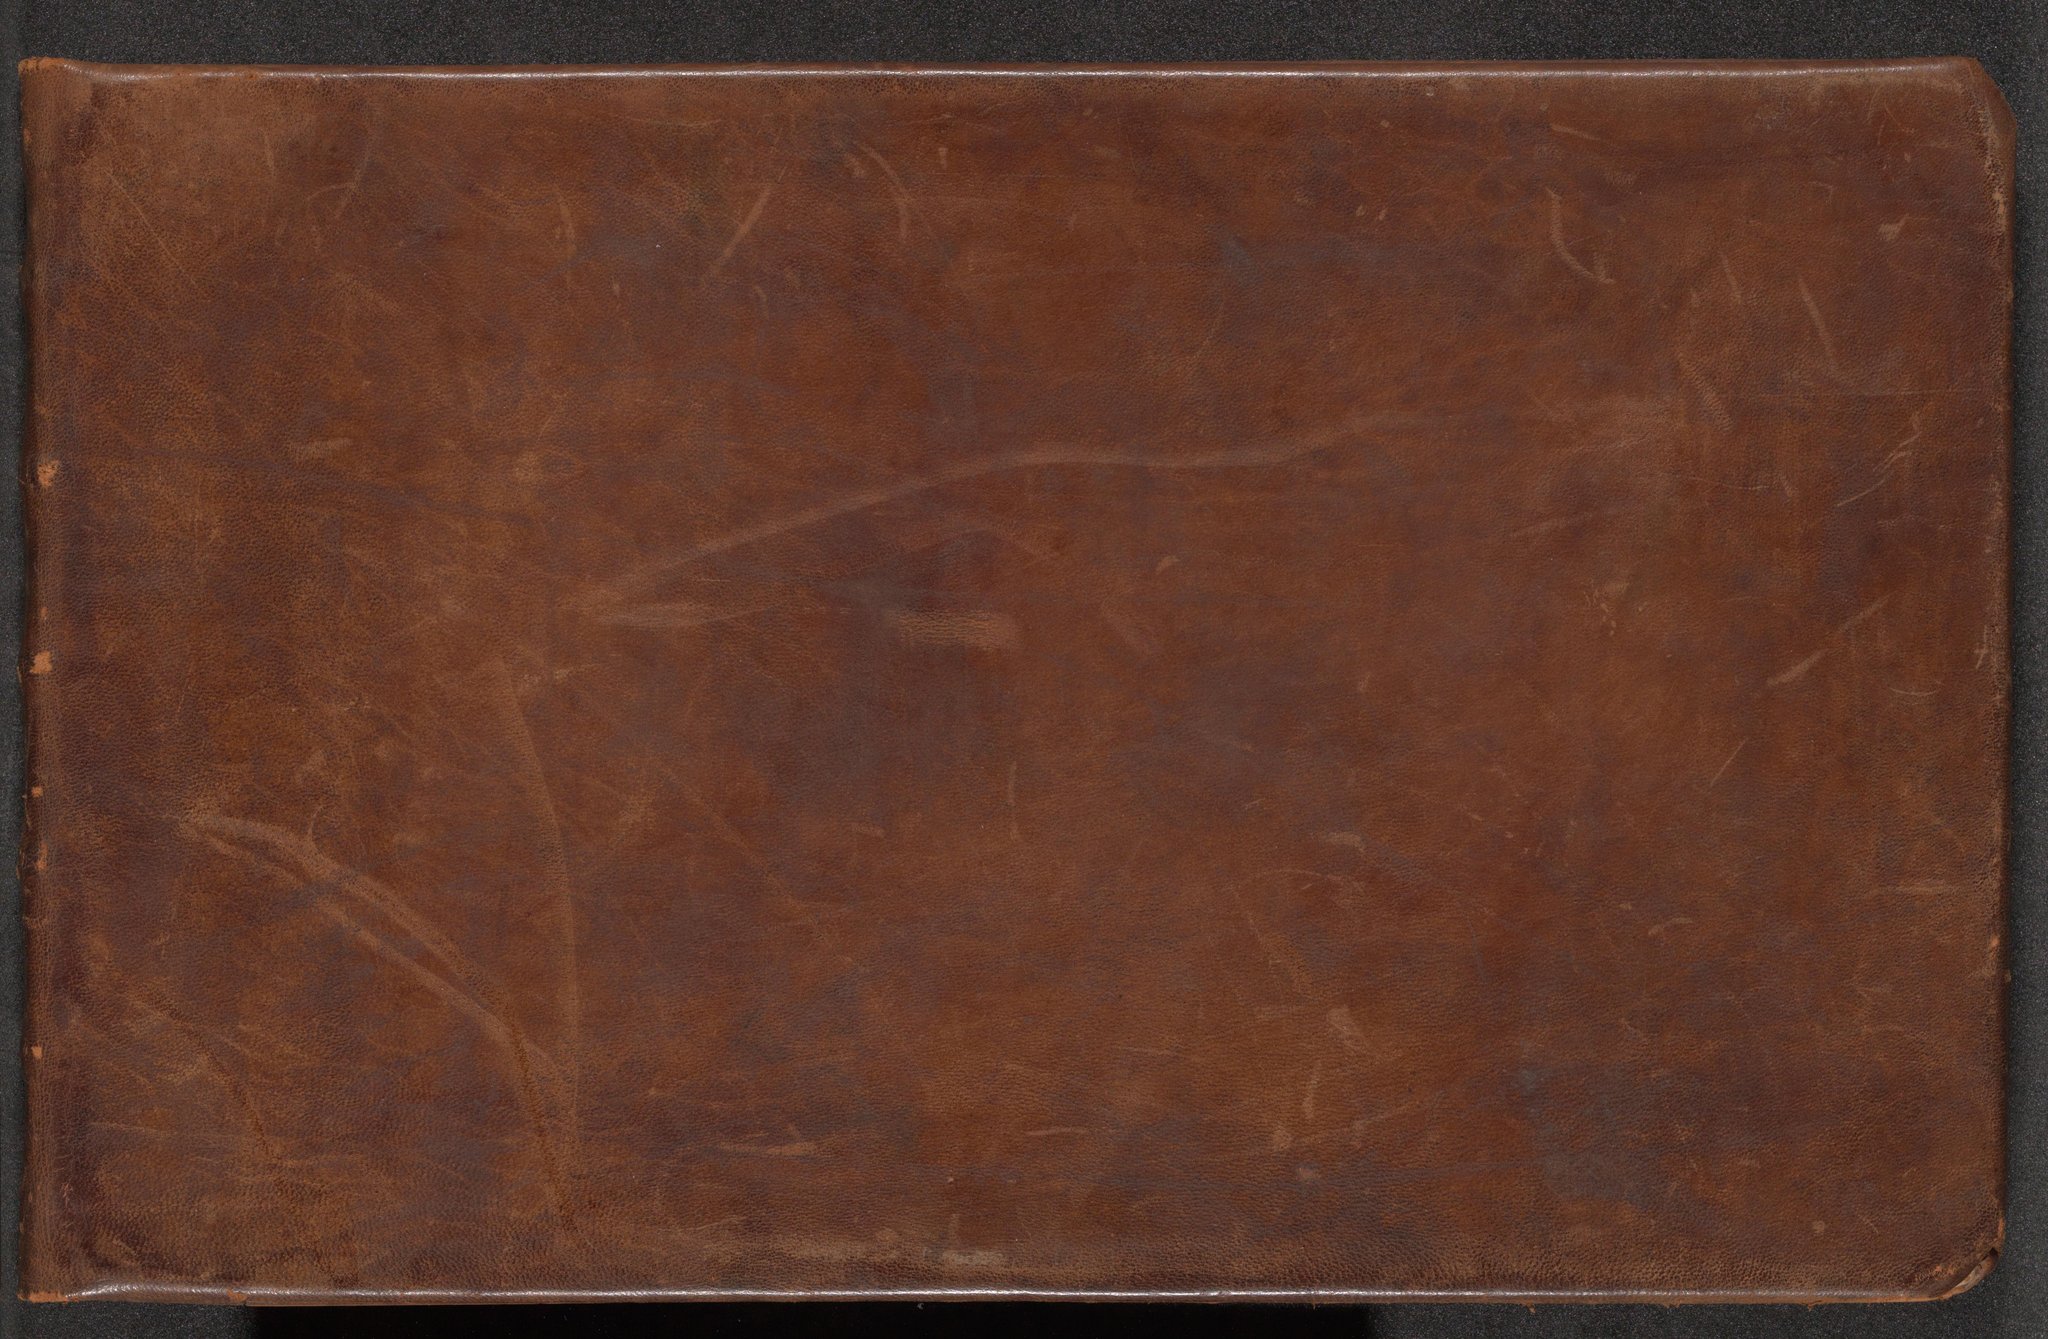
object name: prentrecueil, prentenalbum, prentalbum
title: Album met voorstellingen van planten, dieren en volkeren van West- en Oost-Indië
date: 1682-1733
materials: leather, paper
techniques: bookbinding, etching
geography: amsterdam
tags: oost-indië, west-indië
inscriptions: inscription: ‘Bureau ..... ch ... B. 20’, collector's mark: ‘Bibliotheek Rijksmuseum Amsterdam’, inscription: ‘Eliz.th Cristall 1794’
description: Album met 48 voorstellingen op 47 albumbladen. Het album bevat de serie getiteld: Les Indes Orientales et Occidentales, et autres lieux. Het gaat om een titelprent, zes kaarten (genummerd b t/m g) en veertig voorstellingen van planten, dieren en volkeren in West- en Oost-Indië. De serie wordt besloten met een vignet. Leren band met achterin een schutblad.